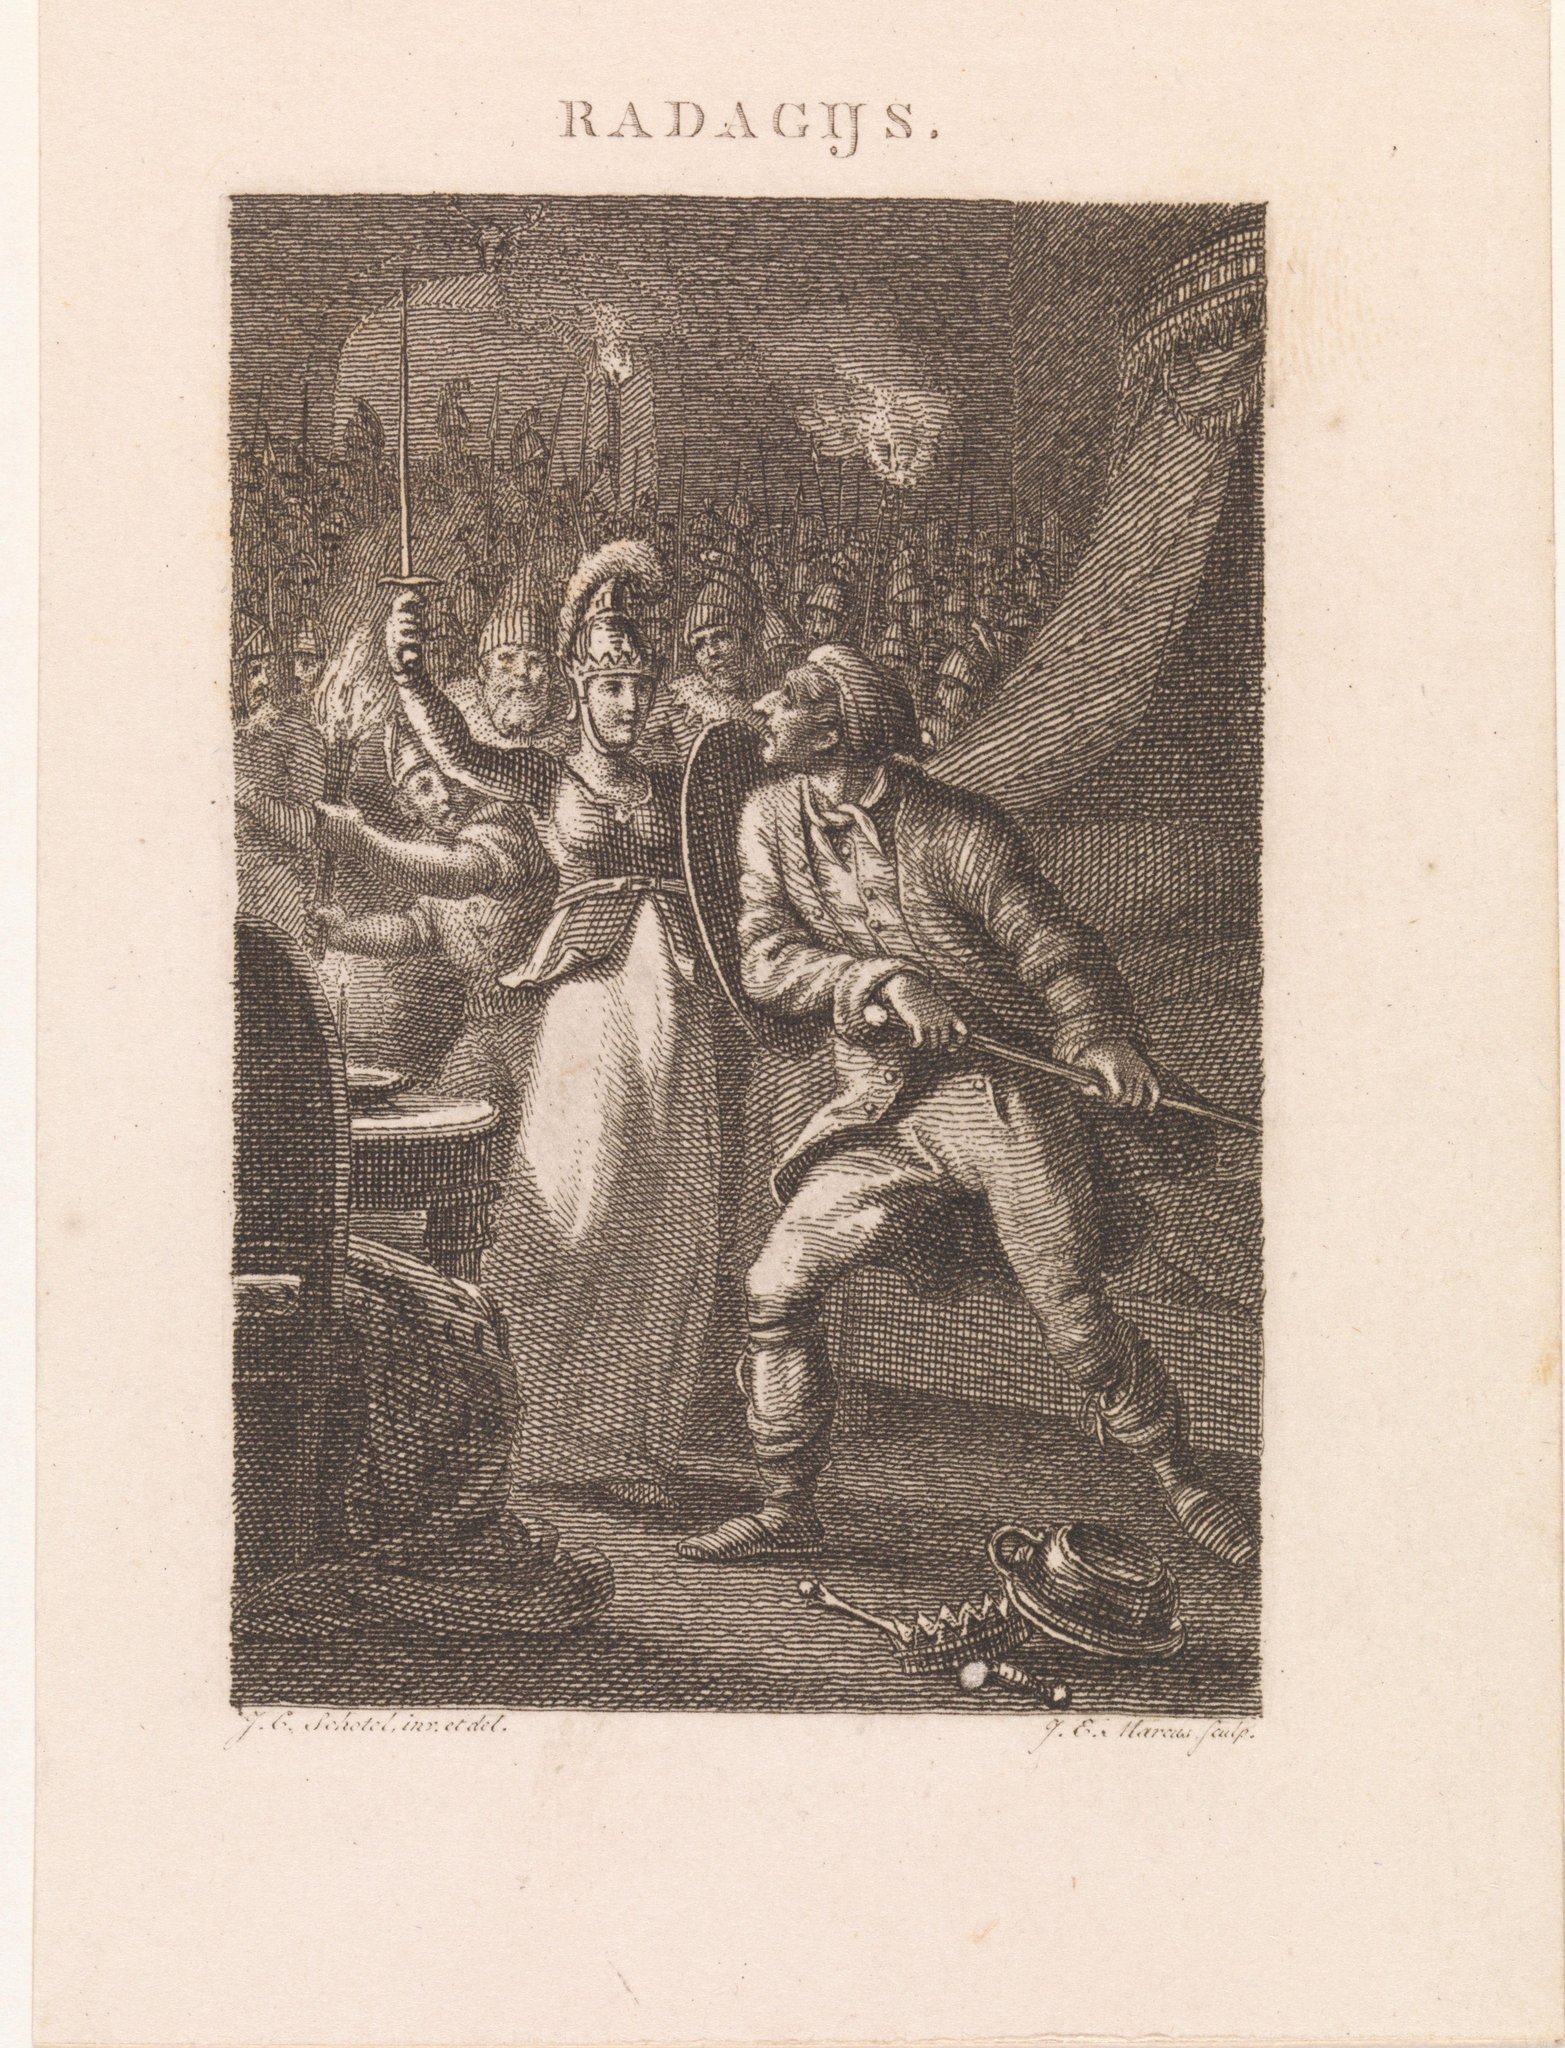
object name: print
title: Radagijs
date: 1819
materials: paper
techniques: etching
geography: amsterdam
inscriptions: collector's mark: Lugt 2228, inscription: ‘Ned. Muzen Alm. 1819’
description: Radagijs, koning van Warmond, trekt zijn zwaard tegen de afgunstige Thiedlinde, die uit jaloezie op de liefde van Radagijs en zijn vrouw, hem met een leger komt aanvallen.